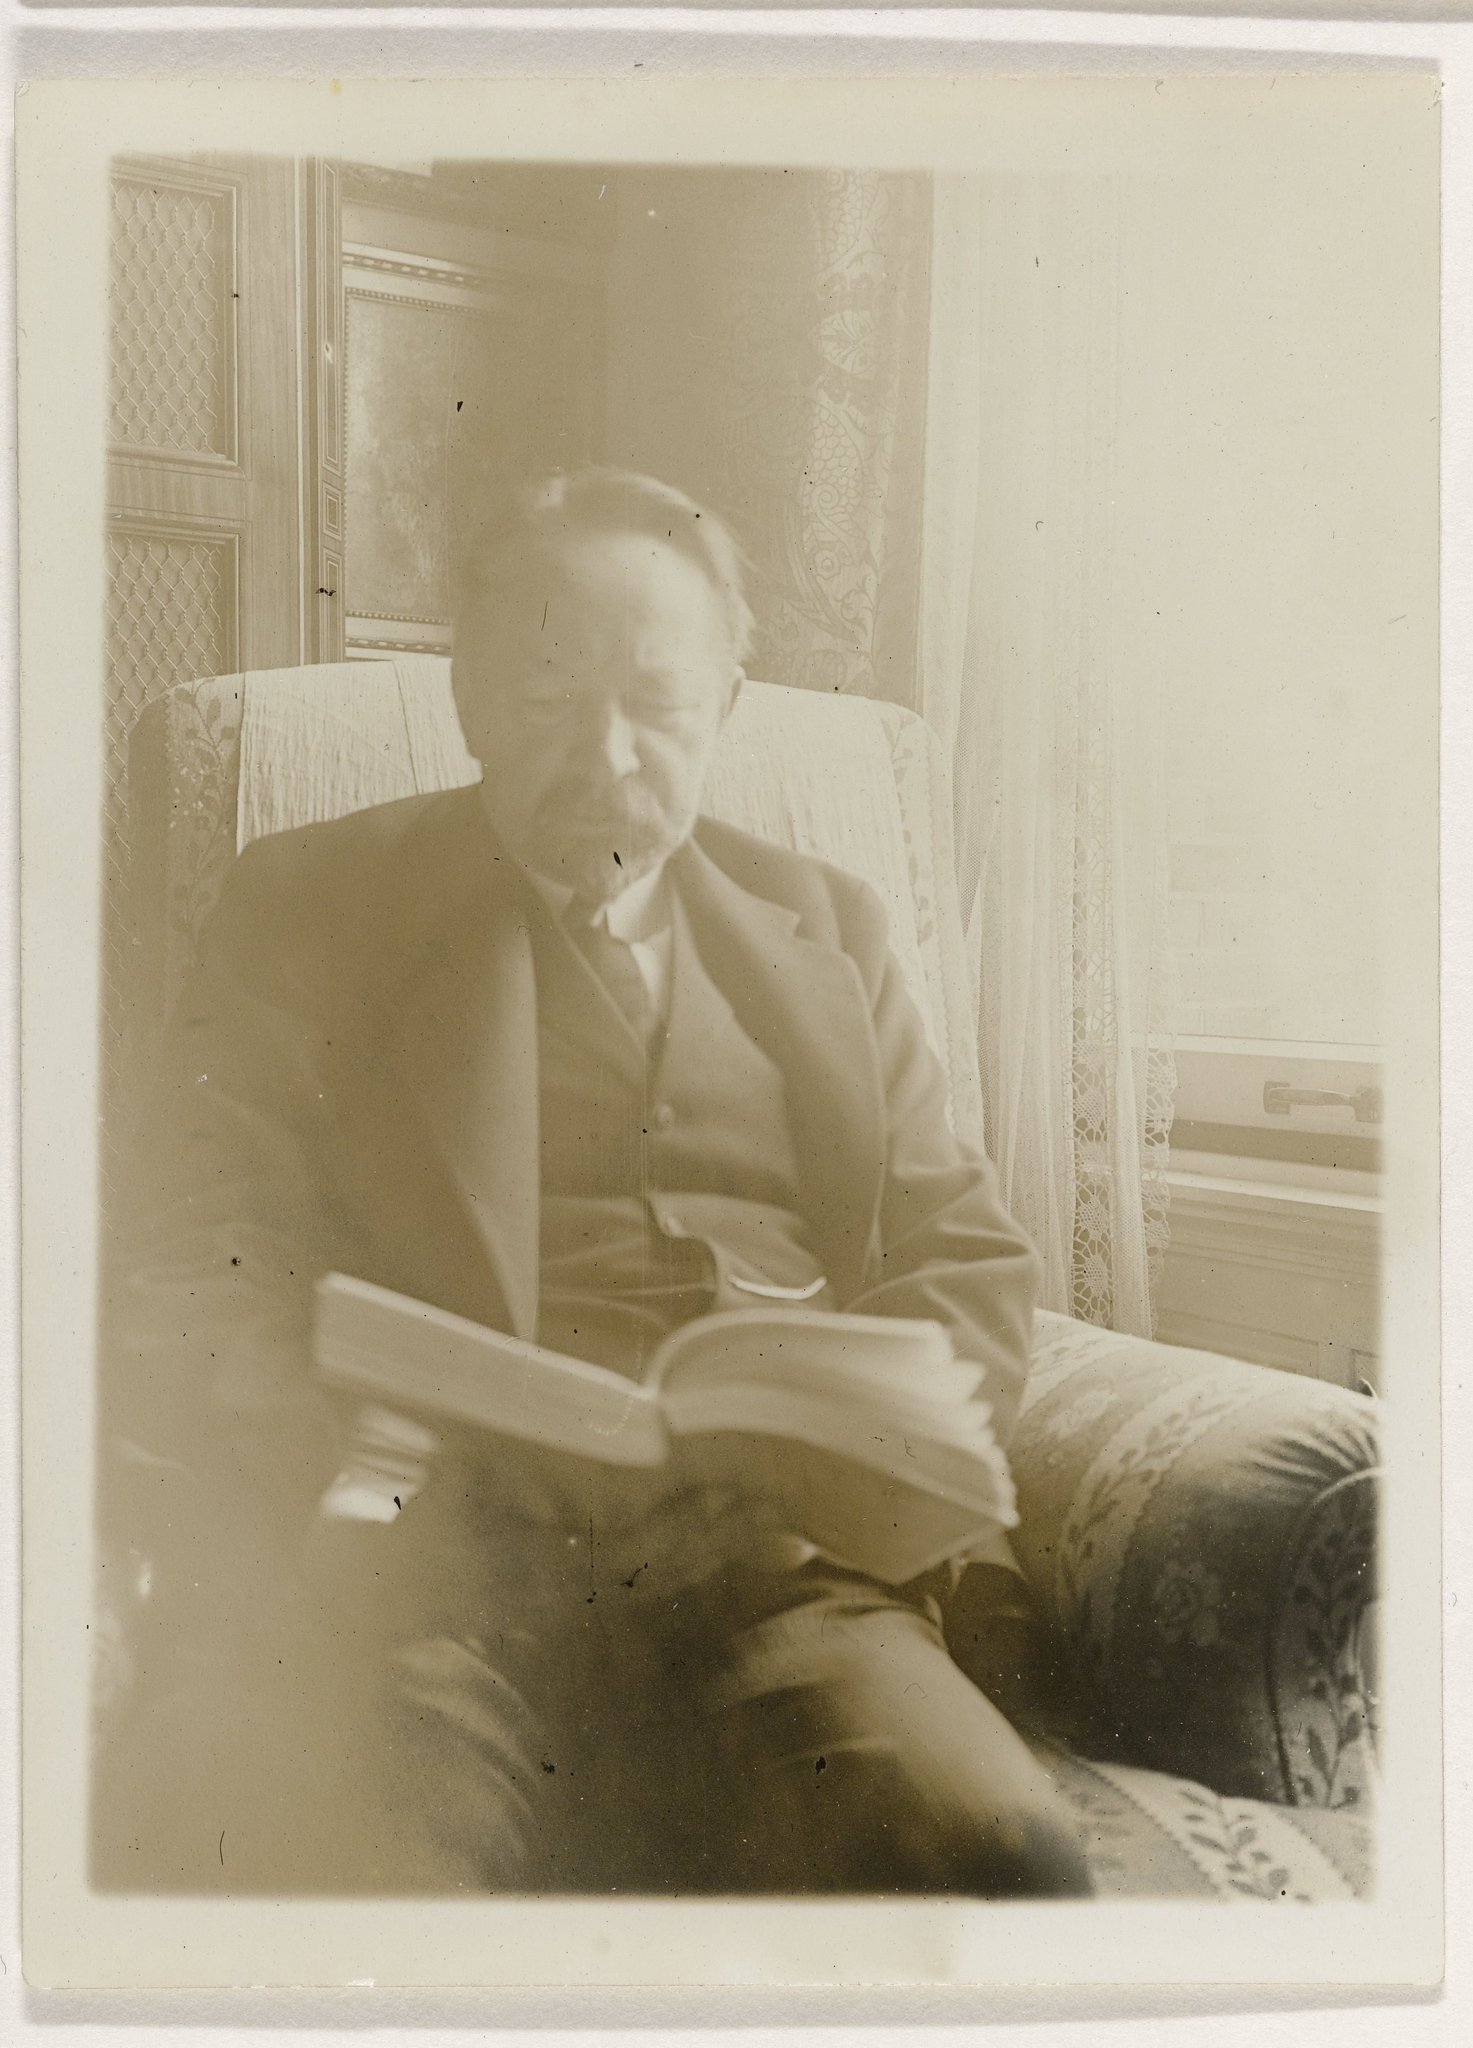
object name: photograph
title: Andries Bonger, in leunstoel, een boek lezend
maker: Anonymous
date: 1910-1930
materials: cardboard, paper, photographic support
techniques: gelatin silver print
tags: andries bonger, reading, historical persons, other dwelling types, amsterdam